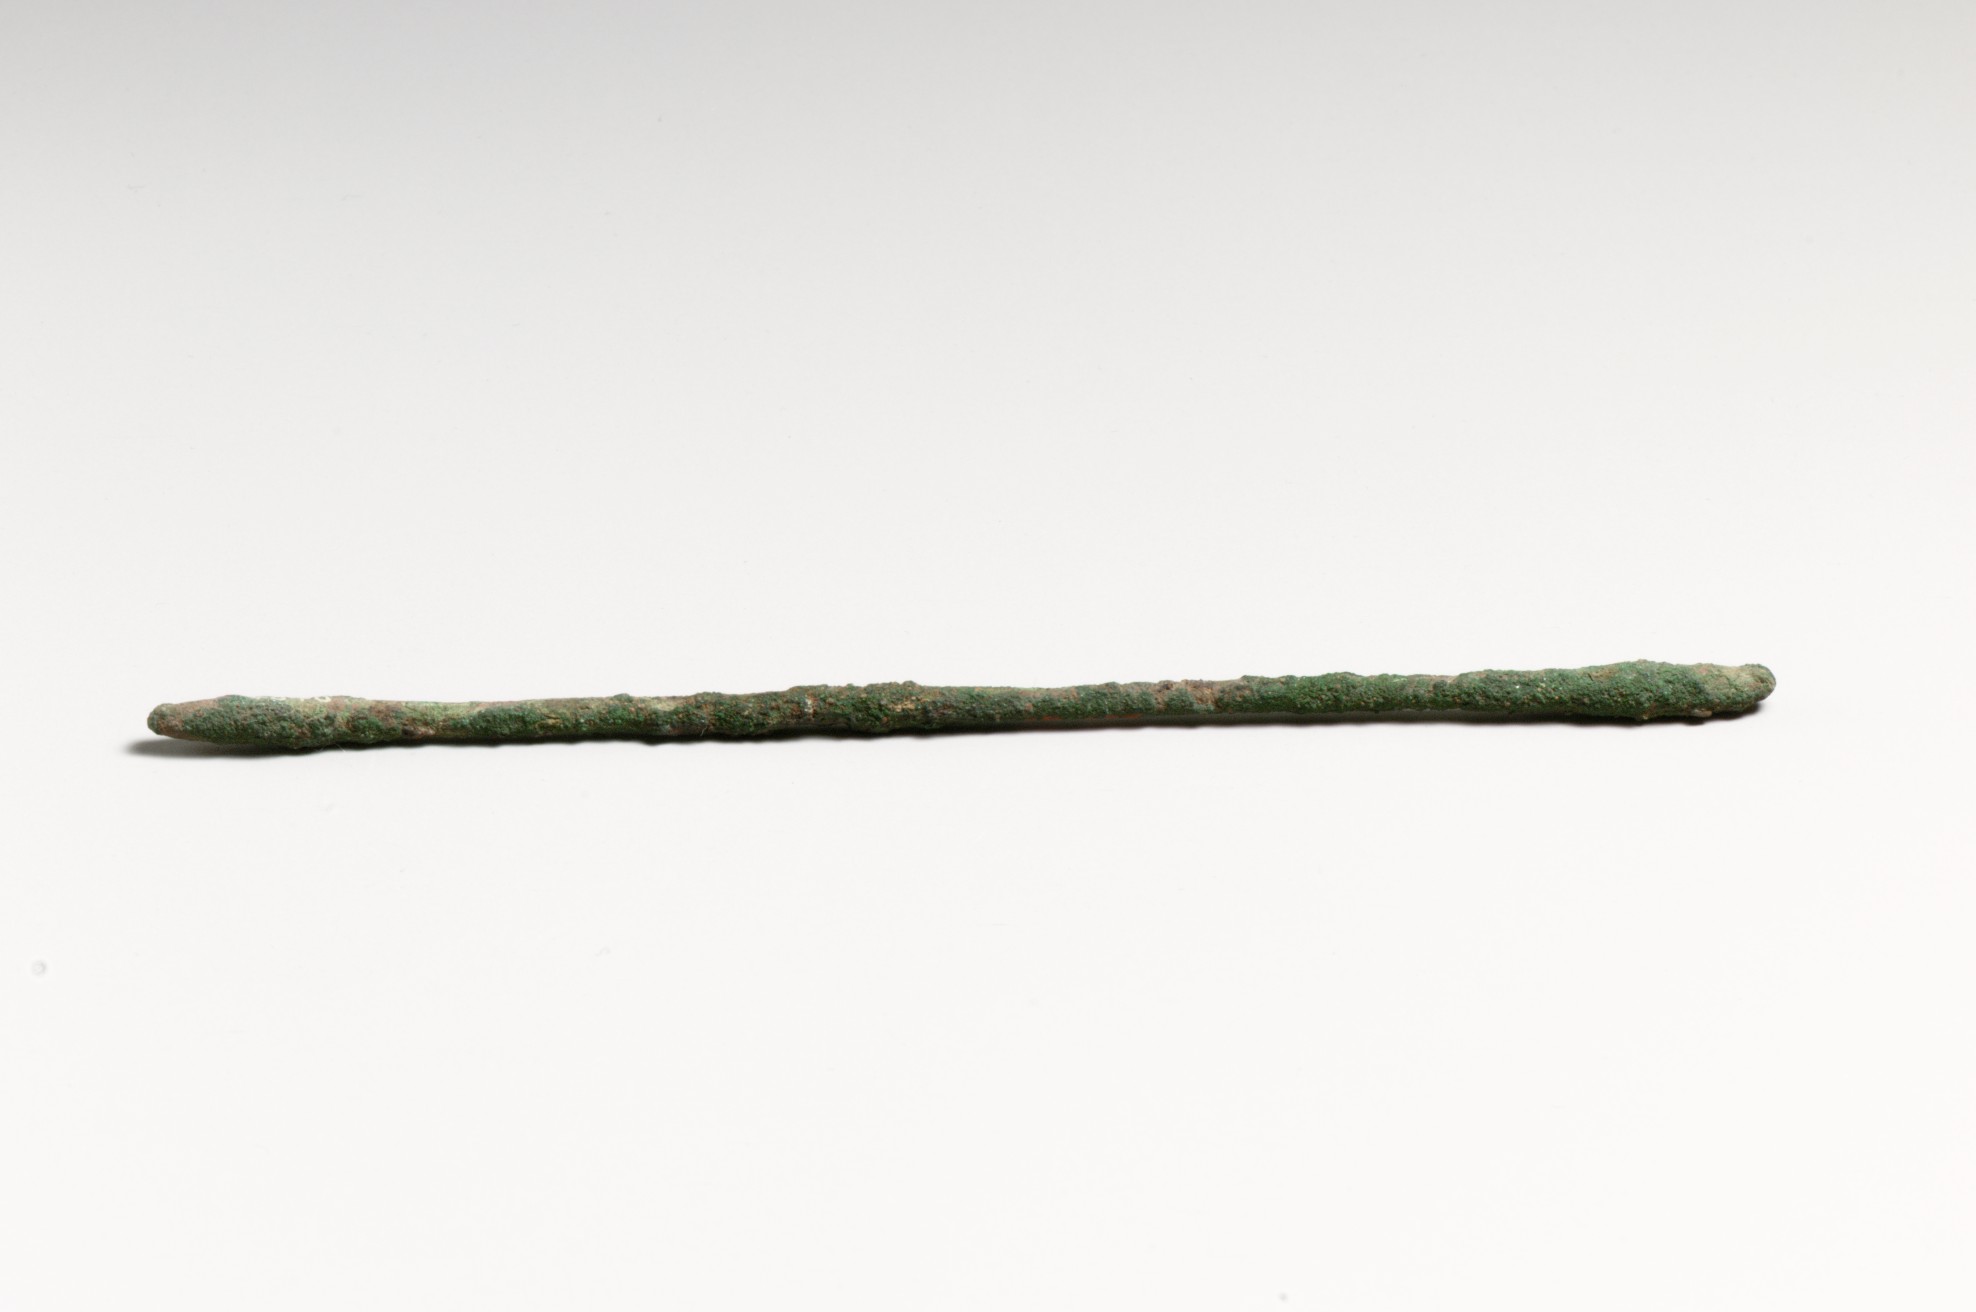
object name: probe, double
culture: cypriot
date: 3900 BCE-100 CE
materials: bronze